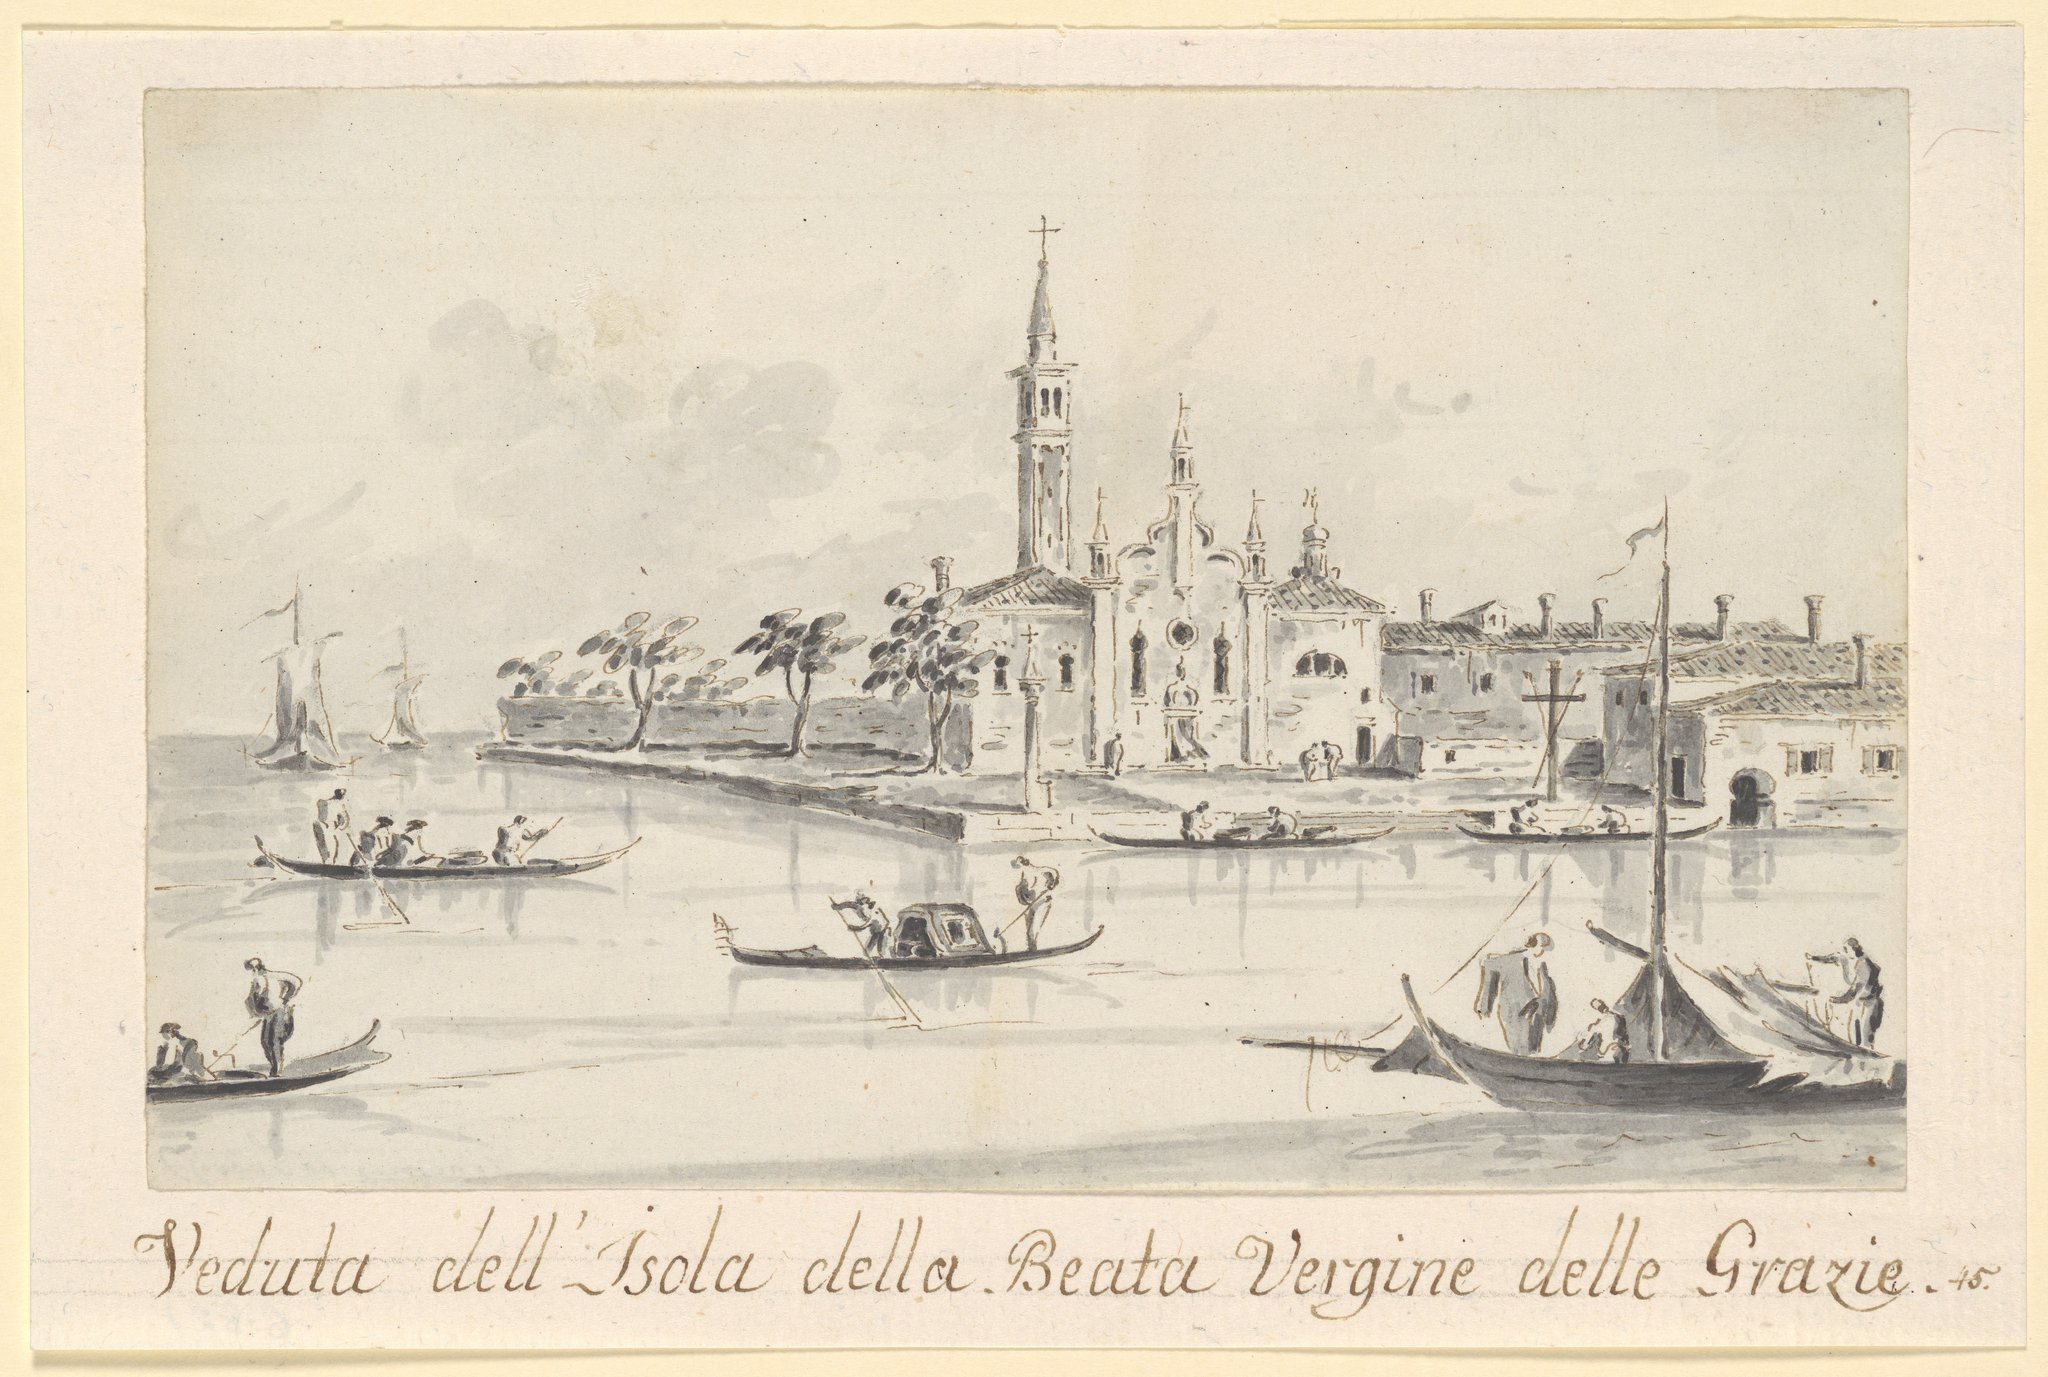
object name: drawing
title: The Island of the Beata Vergine delle Grazie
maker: giacomo guardi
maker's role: artist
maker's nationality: italian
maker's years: 1764-1835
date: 1804-1828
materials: ink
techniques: pen, wash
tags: buildings,boats